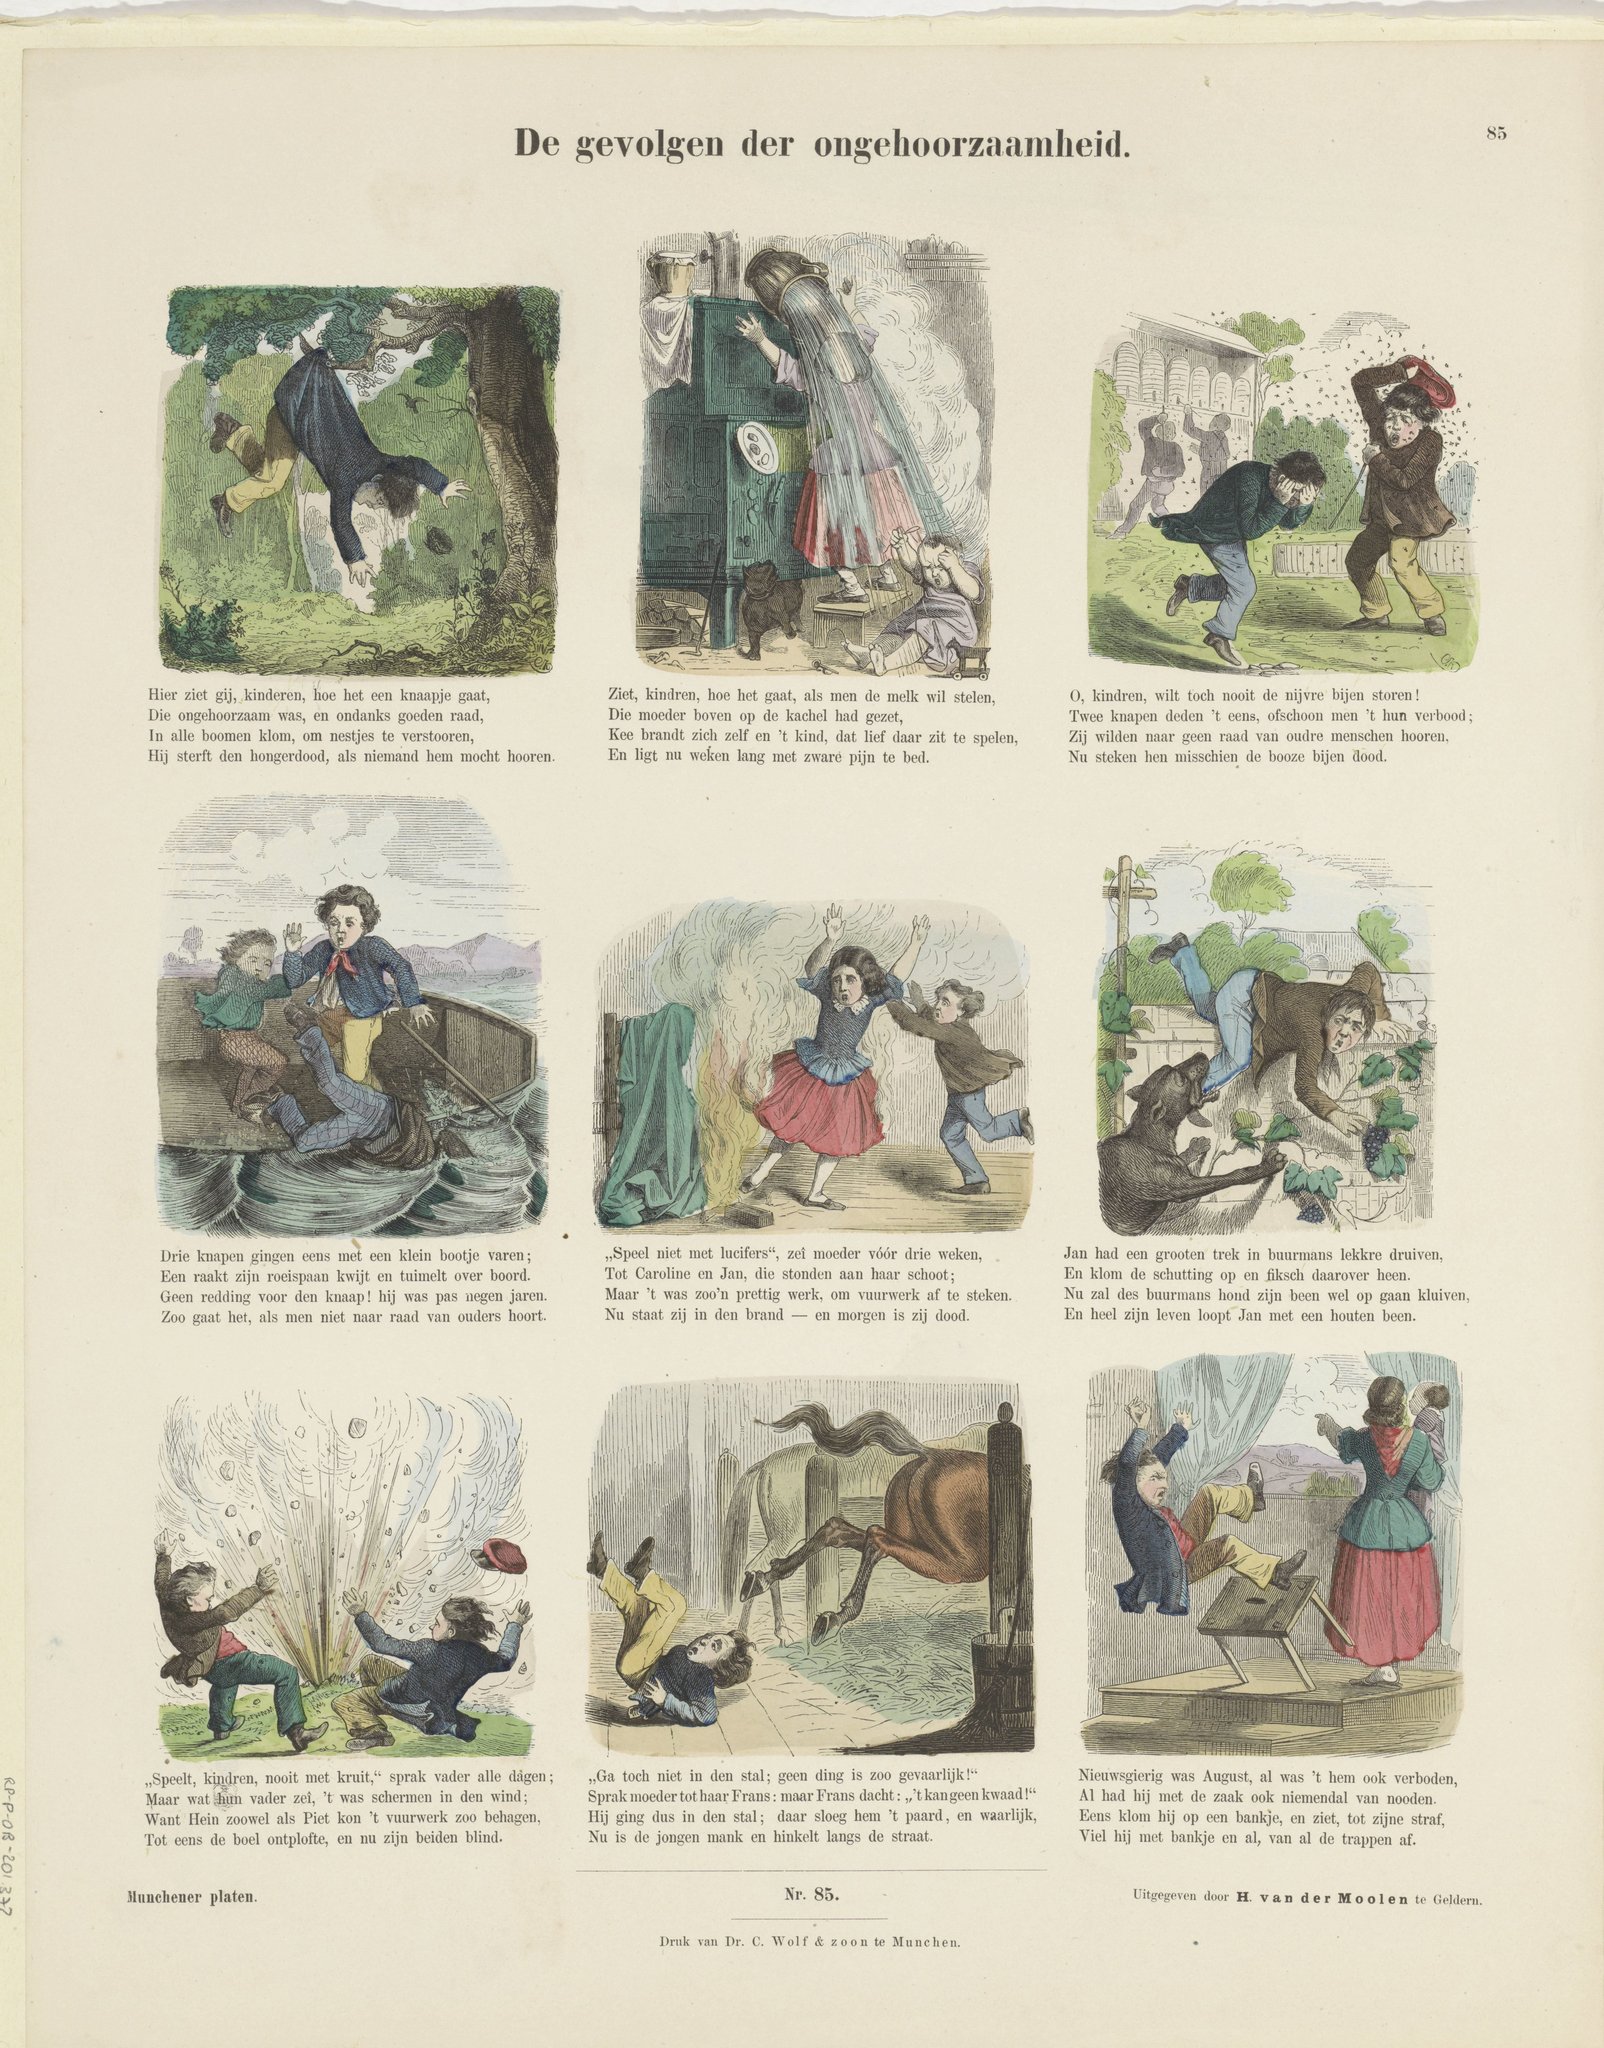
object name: print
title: Munchener platen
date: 1843-1920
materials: paper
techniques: colour, letterpress printing, engraving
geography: munich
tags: mischief-making play, child, bad behaviour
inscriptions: collector's mark: Lugt 2760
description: Blad met 9 voorstellingen over kinderen waarvan de streken slecht uitpakken. Onder elke afbeelding een vierregelig vers. Genummerd midden onder: Nro. 85. Genummerd rechtsboven: 85.